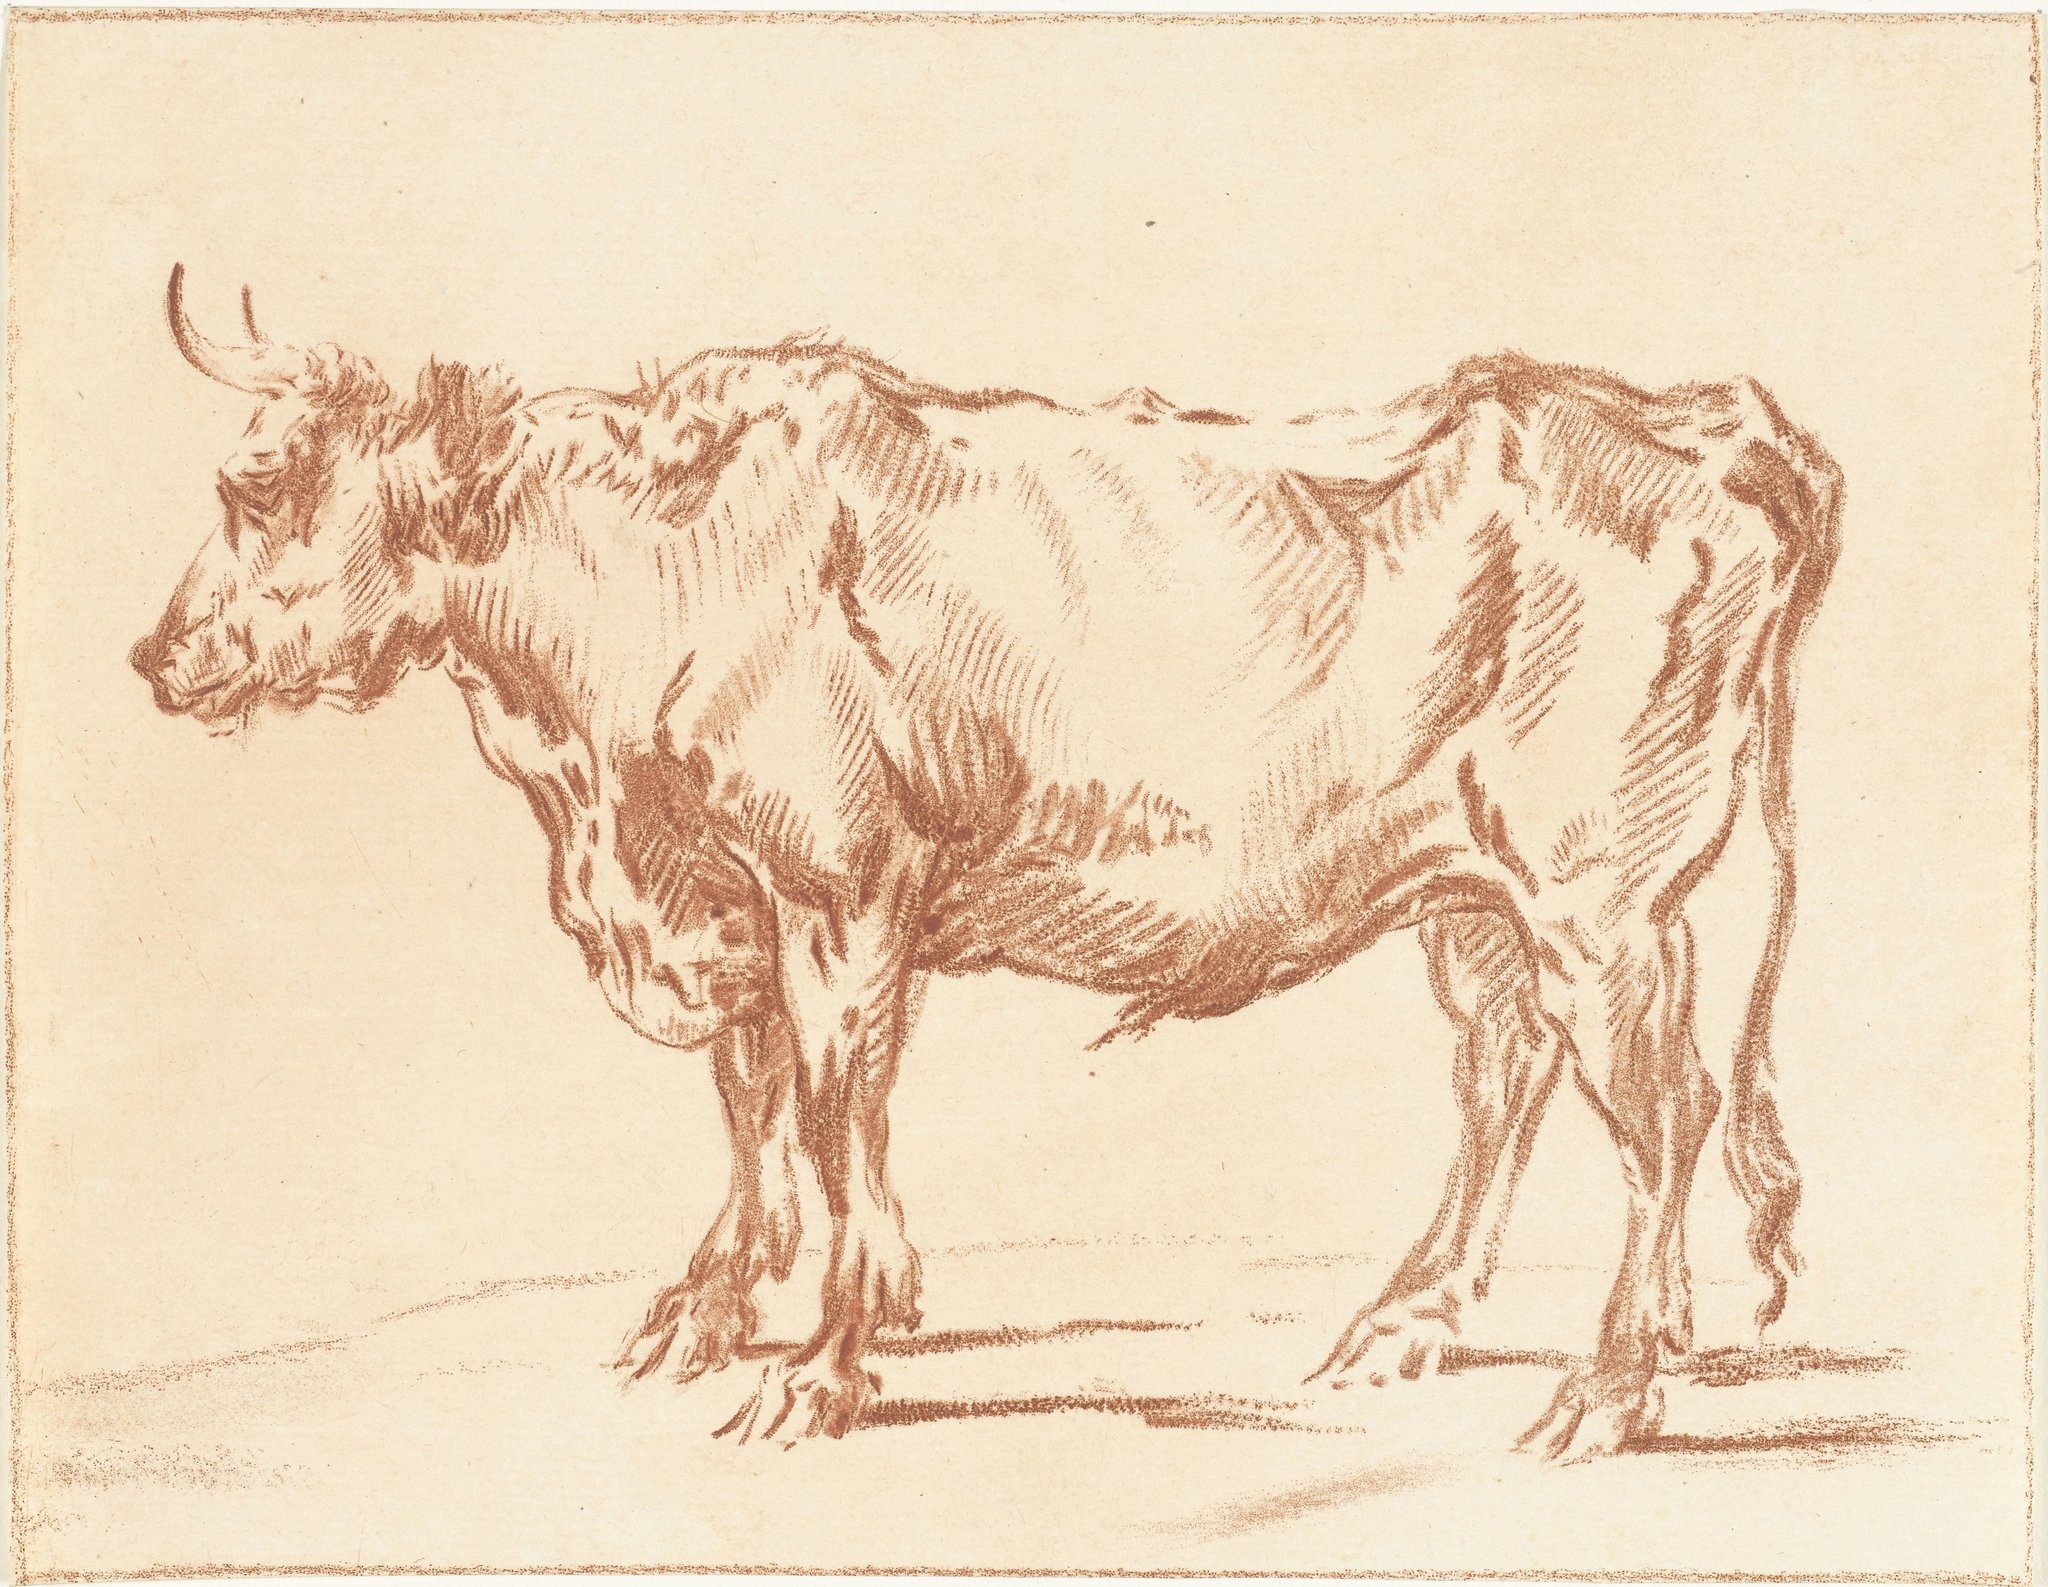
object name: print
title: Staande os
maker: jurriaan cootwijck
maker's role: print maker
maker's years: 1714-1798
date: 1724-1798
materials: paper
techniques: printmaking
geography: amsterdam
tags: ox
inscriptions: collector's mark: Lugt 2228